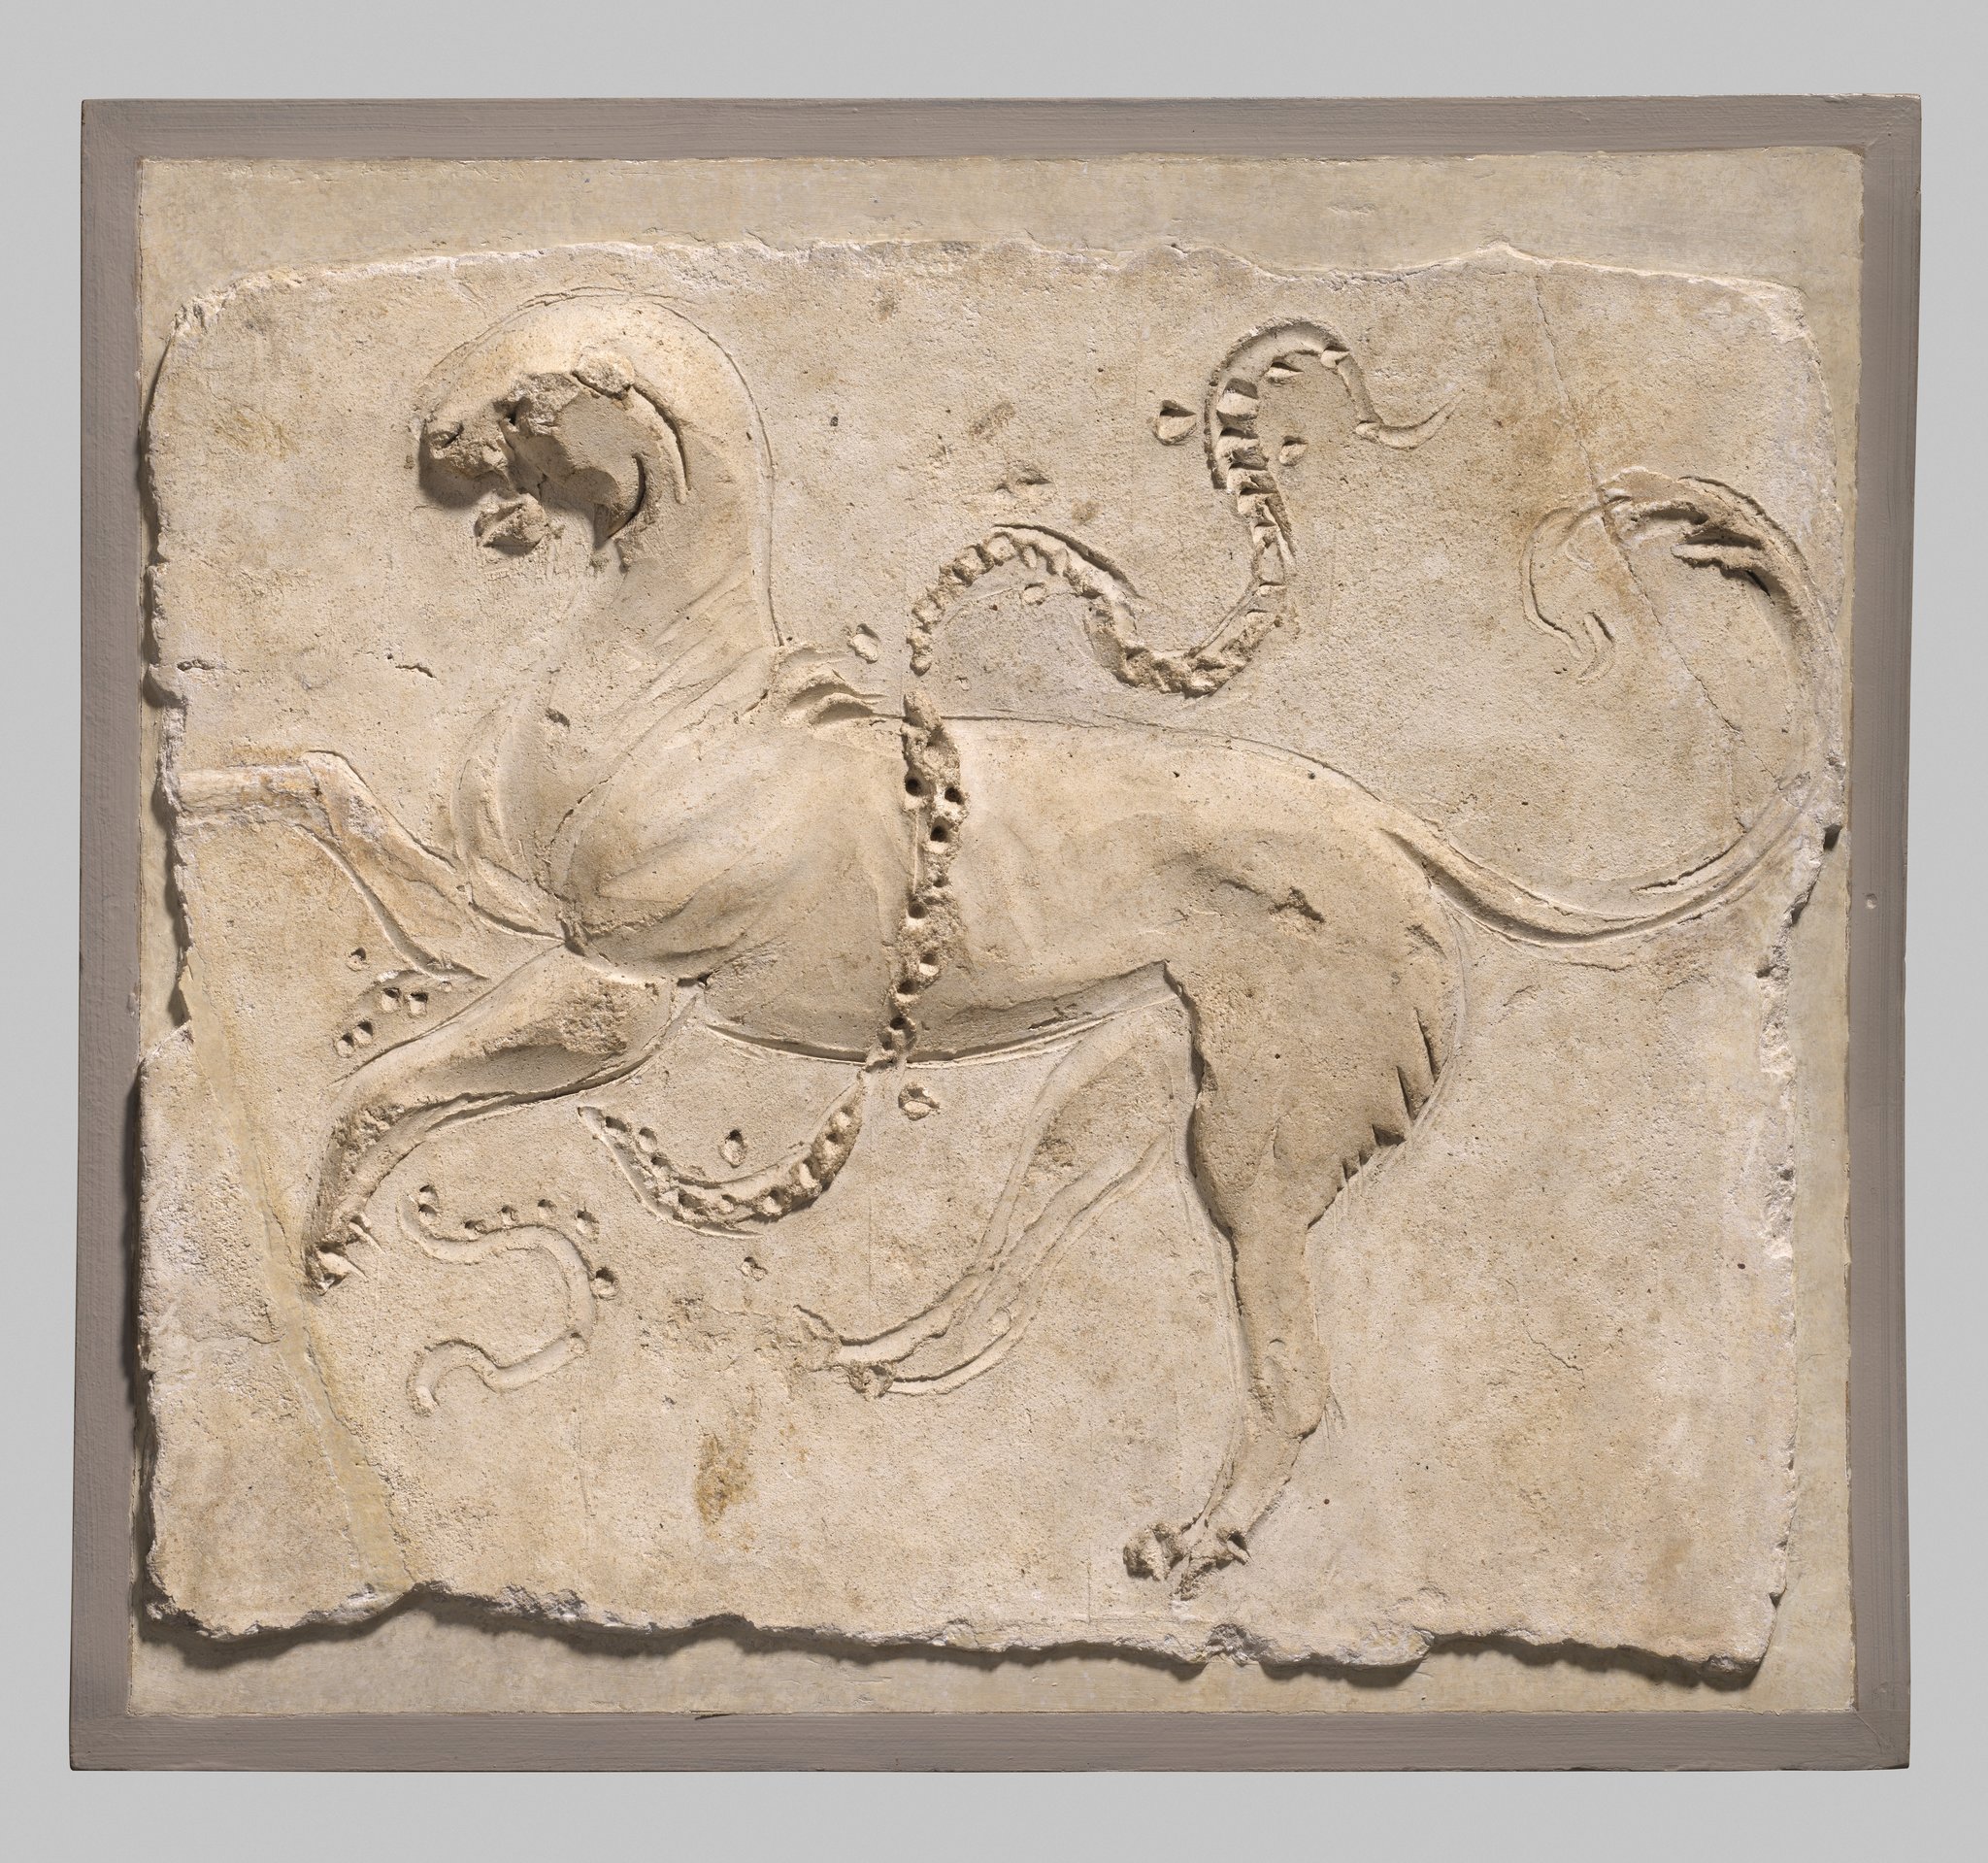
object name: stucco relief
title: Stucco relief panel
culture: roman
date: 51-100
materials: plaster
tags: panthers